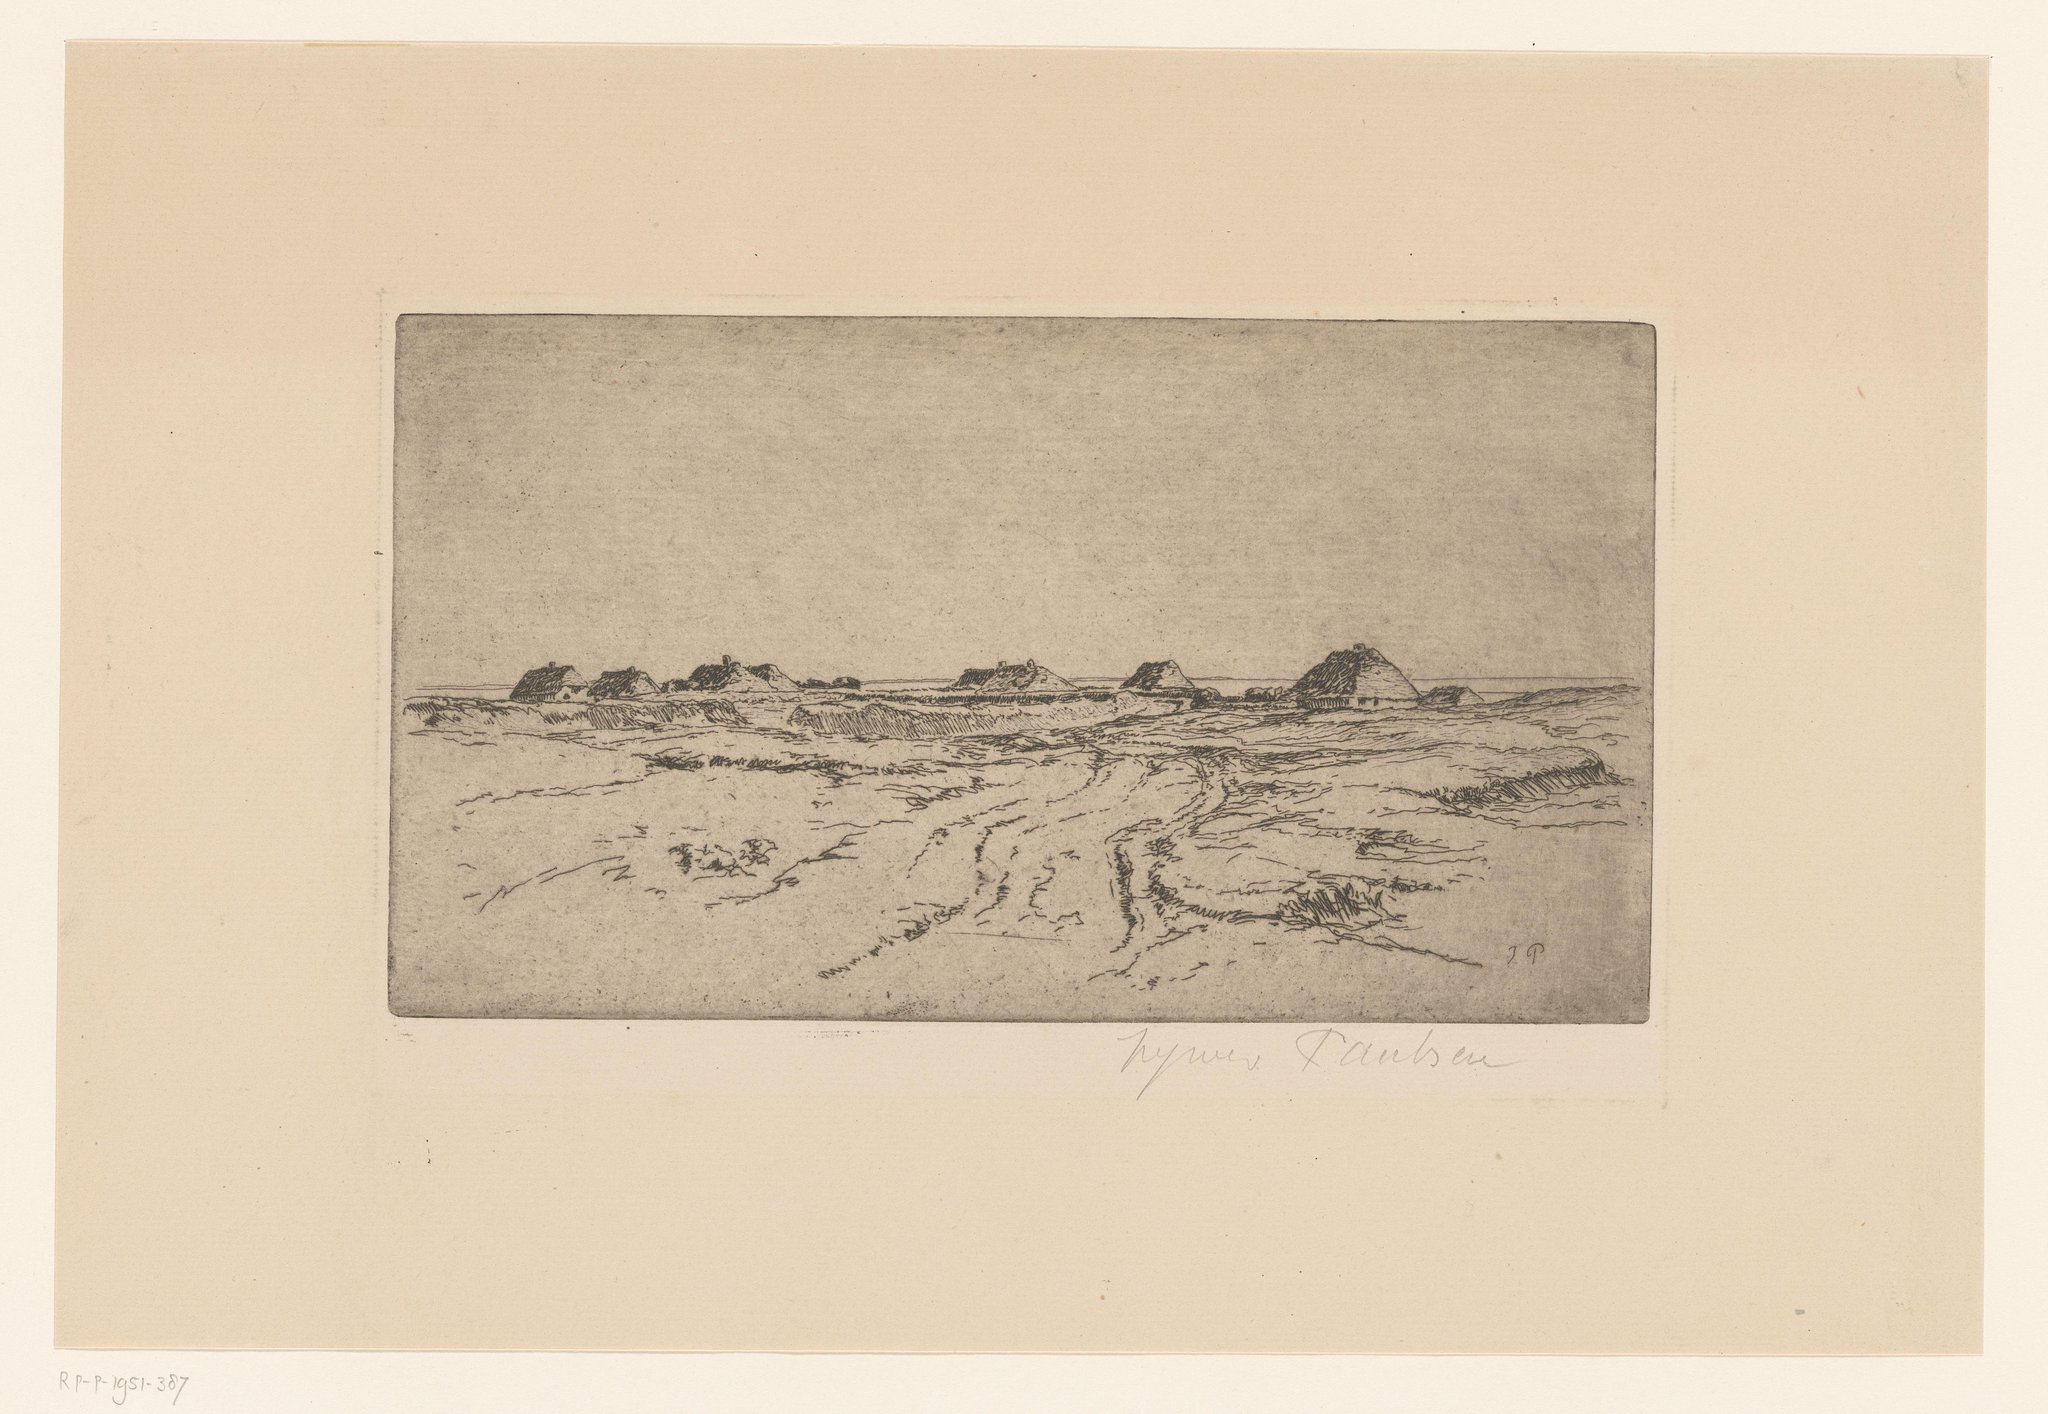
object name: print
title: Vlak land met boerderijen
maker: ingwer paulsen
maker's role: print maker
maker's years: 1883-1943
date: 1893-1943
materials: paper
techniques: etching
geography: scandinavia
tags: landscapes in the temperate zone, village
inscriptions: collector's mark: Lugt 2228